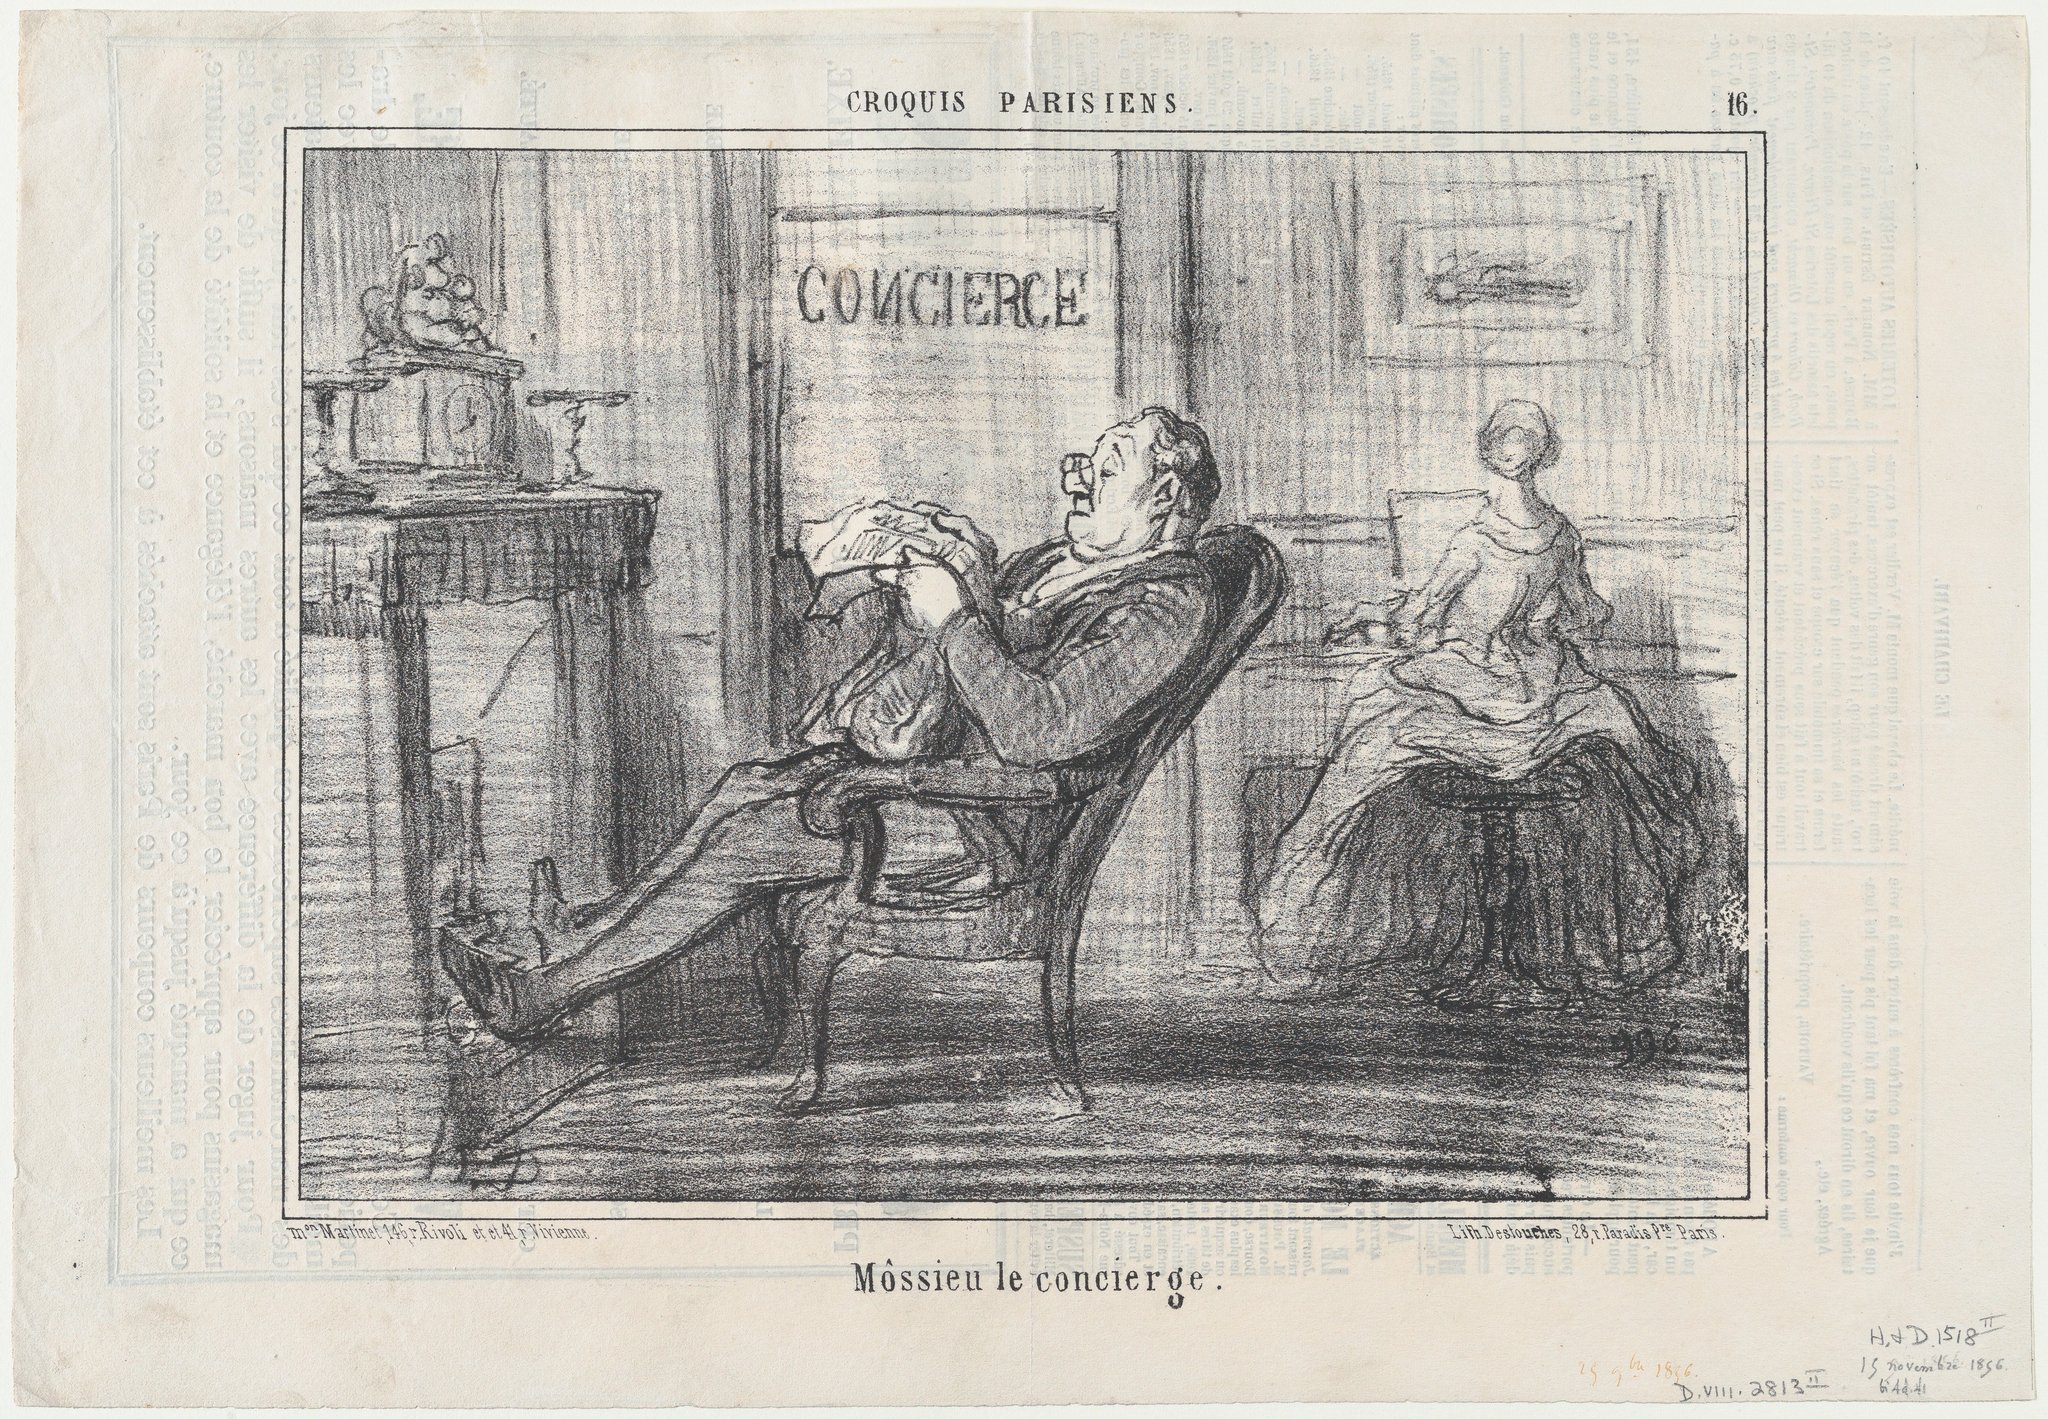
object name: print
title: Môssieu le concierge, from Croquis Parisiens, published in Le Charivari, November 25, 1856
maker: honoré daumier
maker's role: artist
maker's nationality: french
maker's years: 1808-1879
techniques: lithograph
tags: men,reading